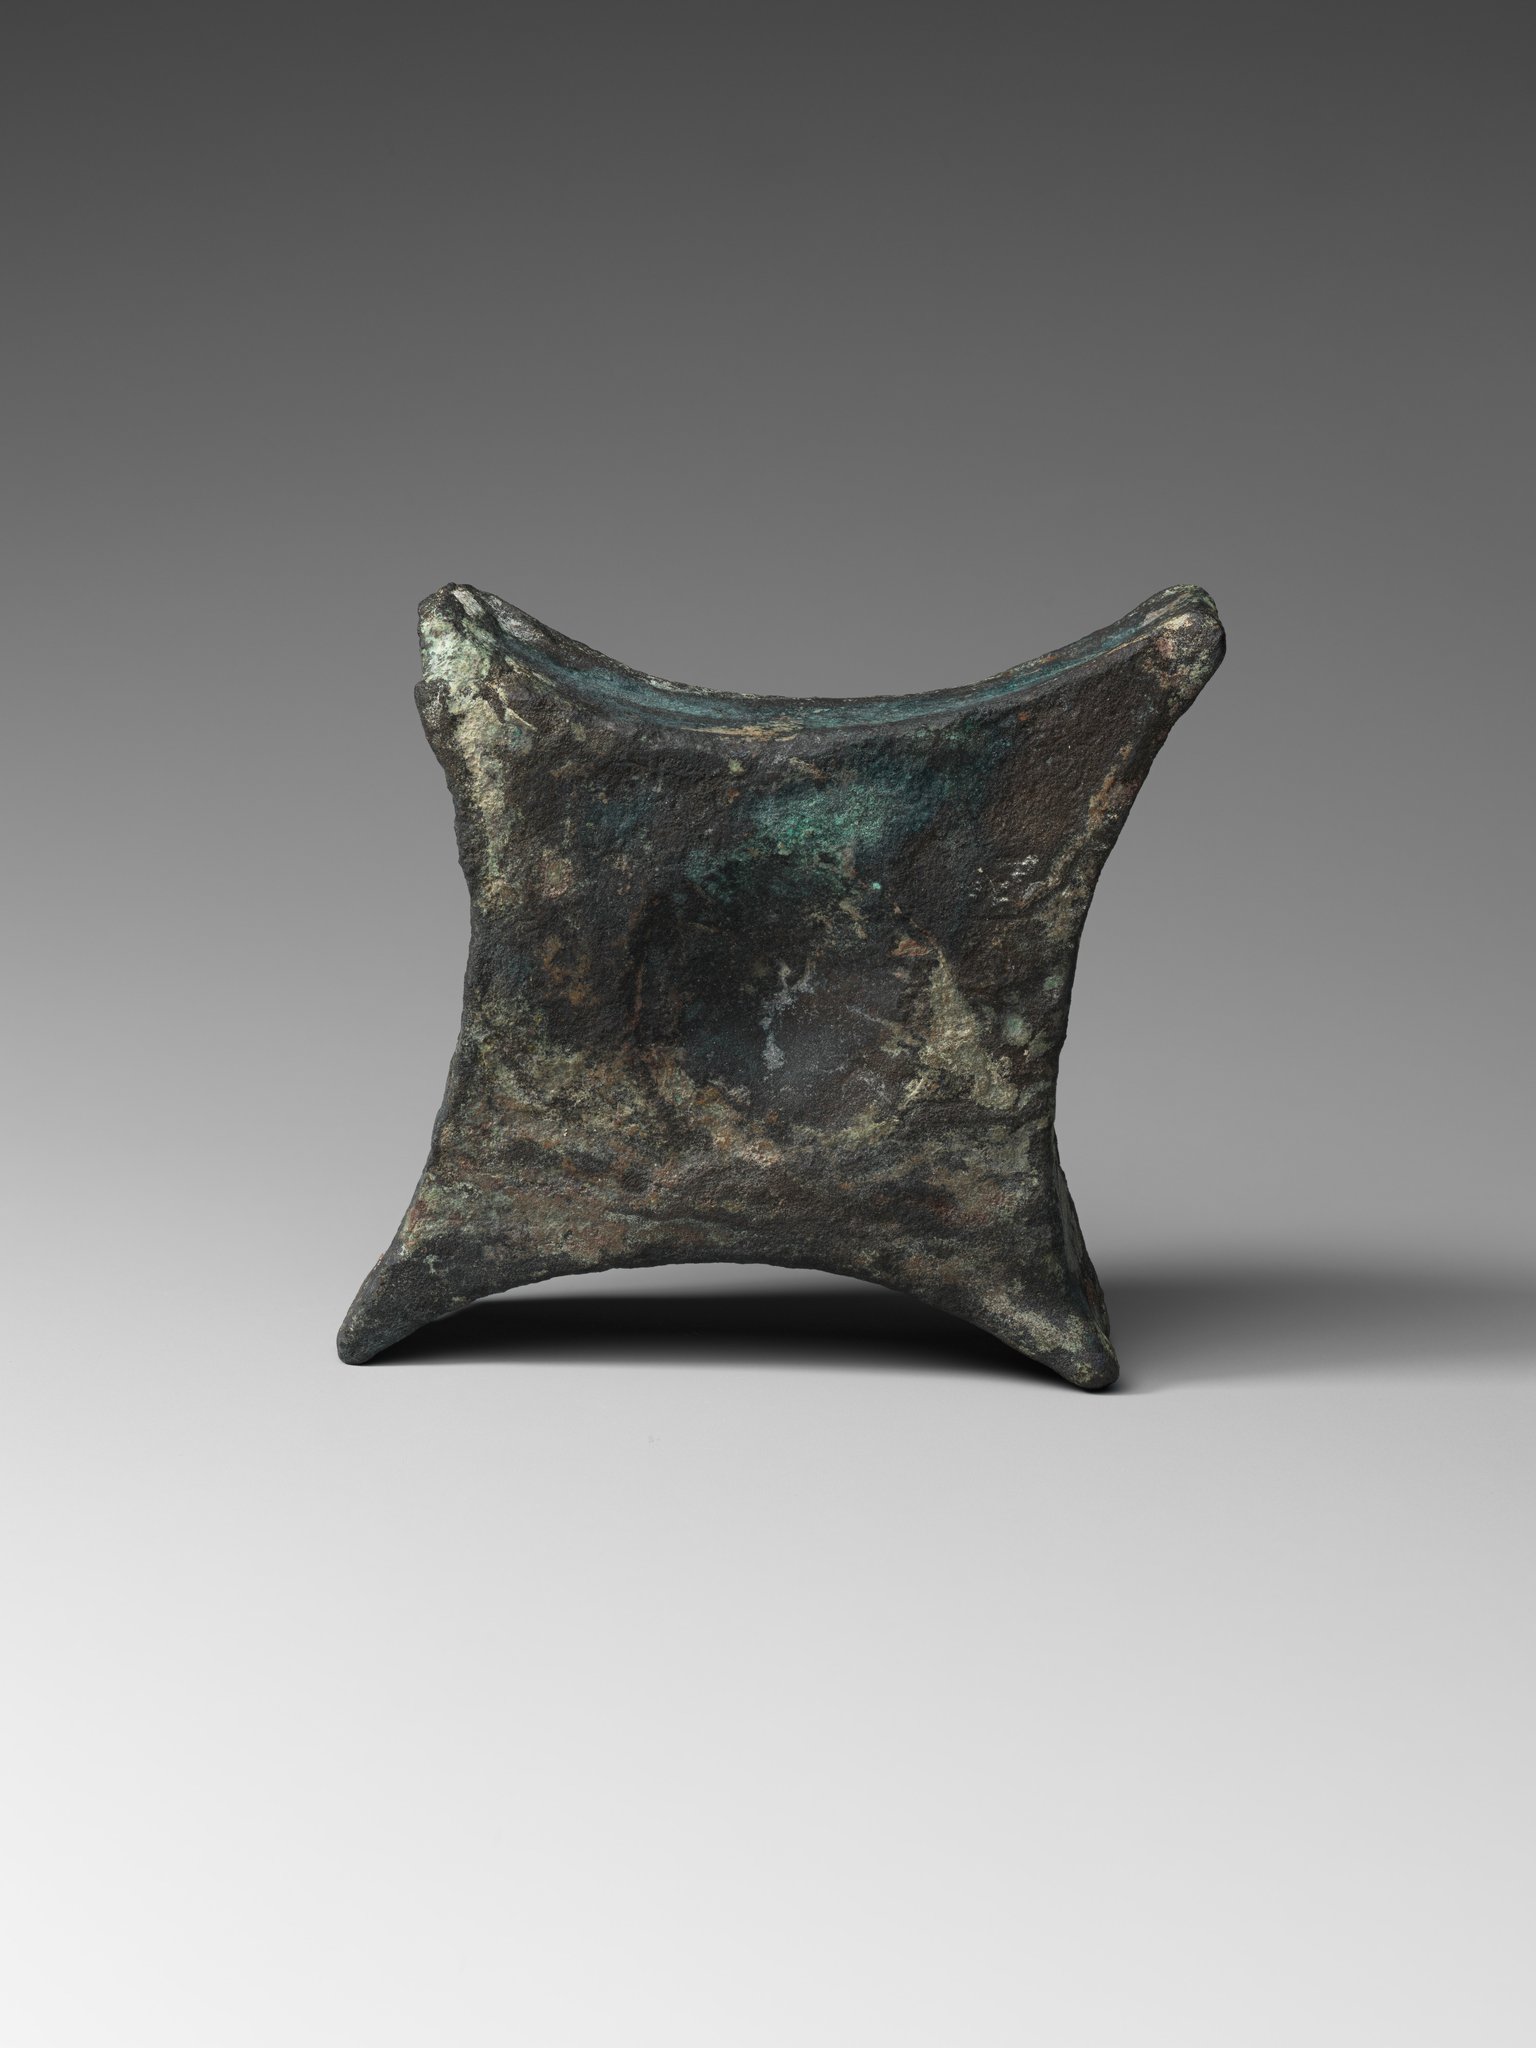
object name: door socket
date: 595-530 BCE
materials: bronze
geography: egypt